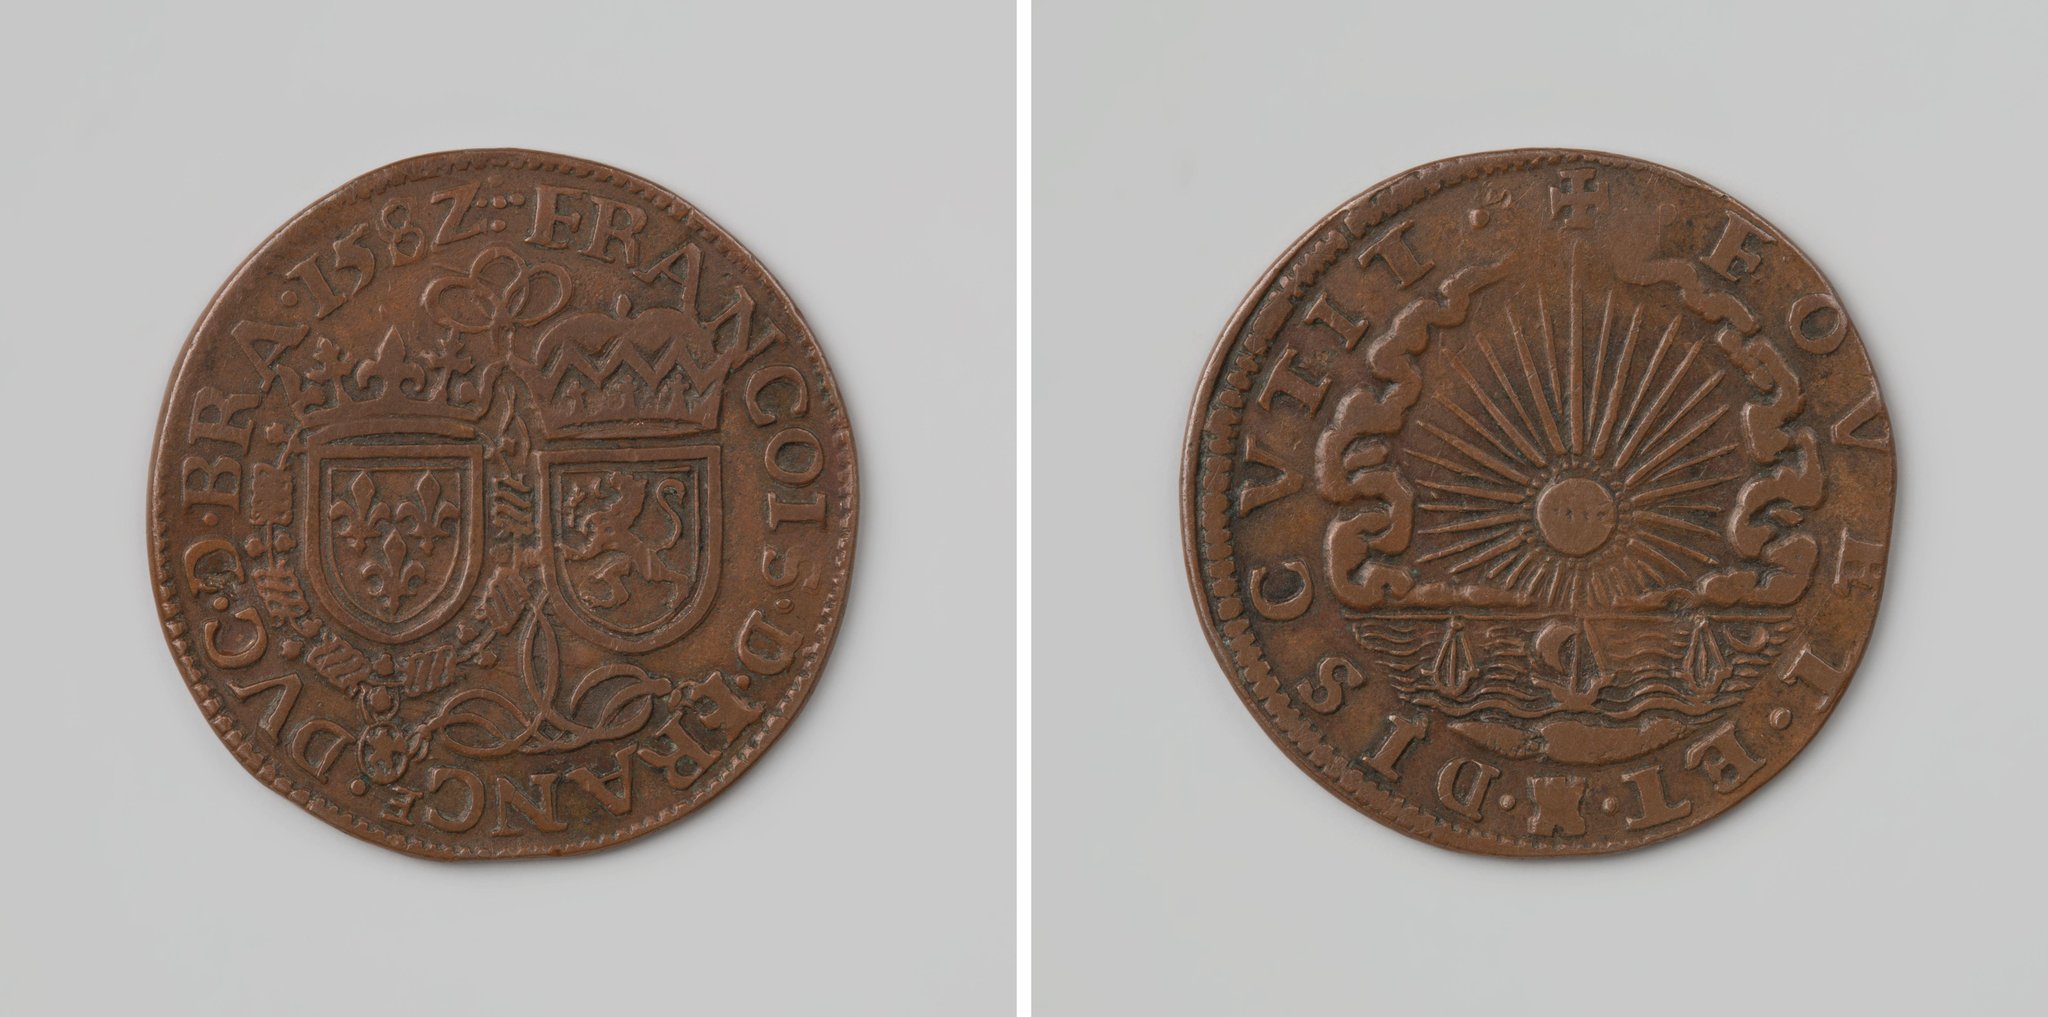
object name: jeton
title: Inhuldiging van Francois-Hercule, hertog van Anjou als hertog van Brabant te Antwerpen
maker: Anonymous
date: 1582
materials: copper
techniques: striking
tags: paris, françois-hercule de valois (hertog van anjou), antwerp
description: Koperen penning. Voorzijde: twee gekroonde wapenschilden, met lint aan elkaar verbonden binnen omschrift. Keerzijde: zon verdrijft wolken boven zee, waar schepen op varen binnen omschrift